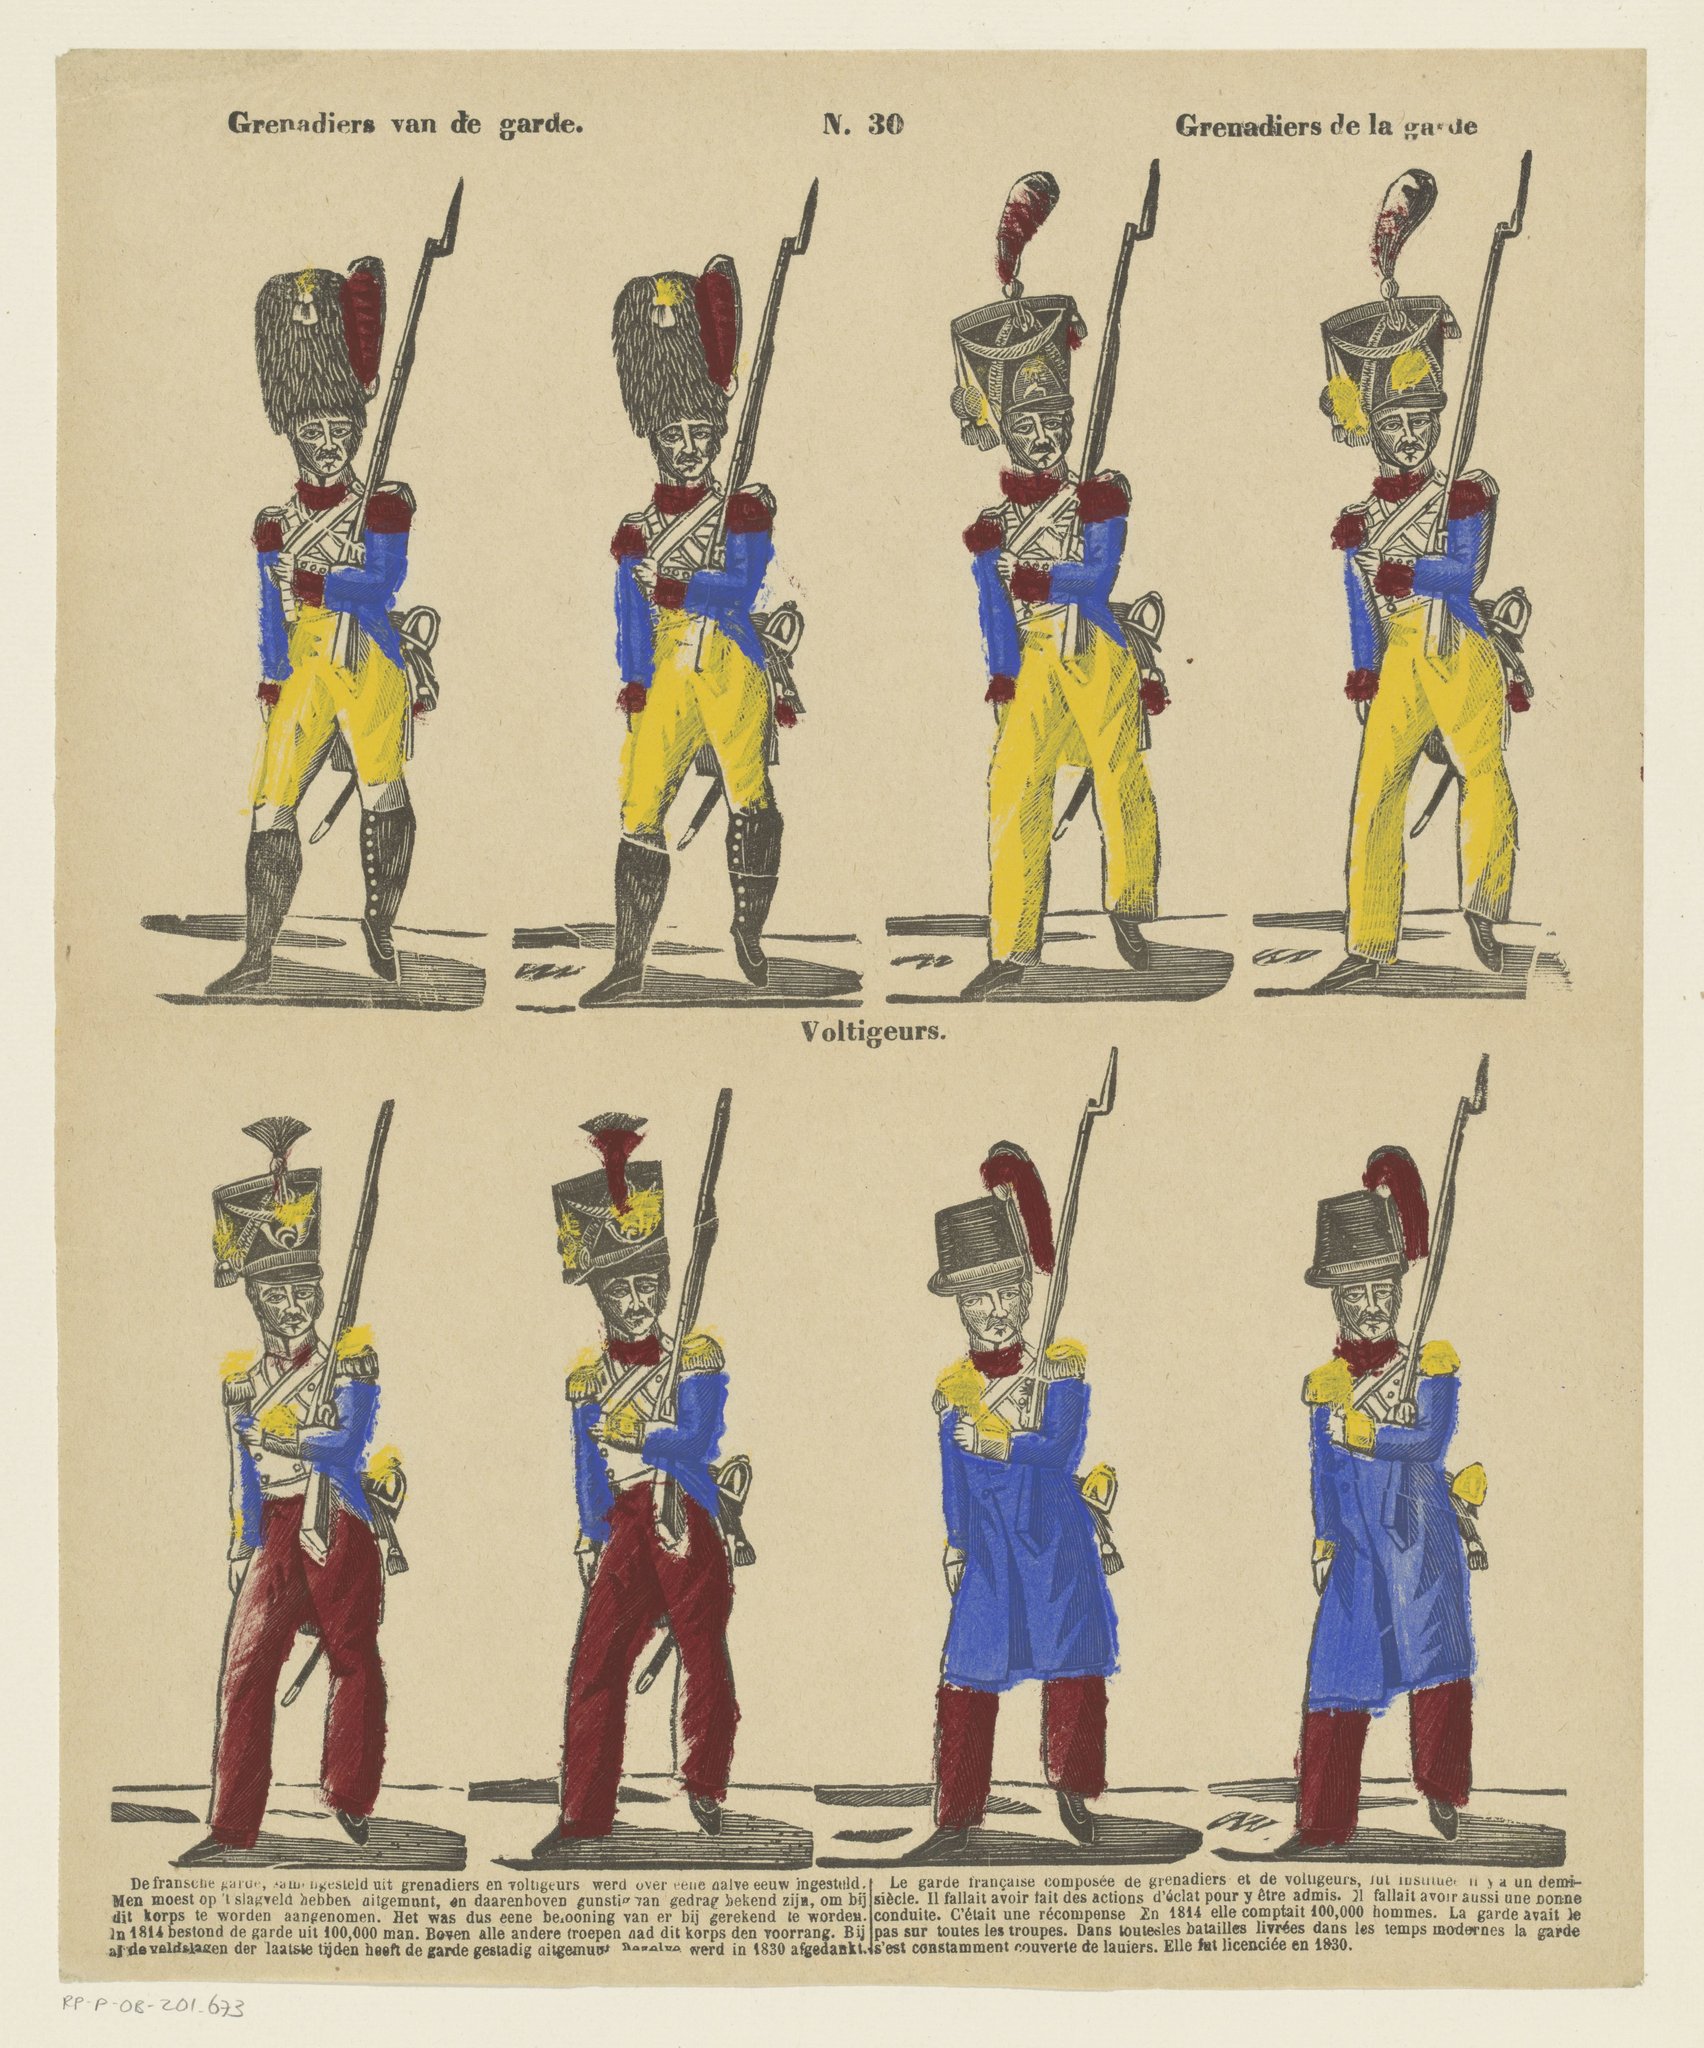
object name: print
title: Grenadiers van de garde / Grenadiers de la garde / Voltigeurs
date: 1800-1833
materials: paper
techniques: colour, letterpress printing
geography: turnhout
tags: private soldier (+ infantry), the soldier; the soldier's life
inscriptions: collector's mark: Lugt 2760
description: Blad met 2 horizontale rijen met voorstellingen van militairen. in de ondermarge een vijfregelig onderschrift in het Nederlands en in het Frans in twee kolommen. Genummerd midden boven: N. 30.